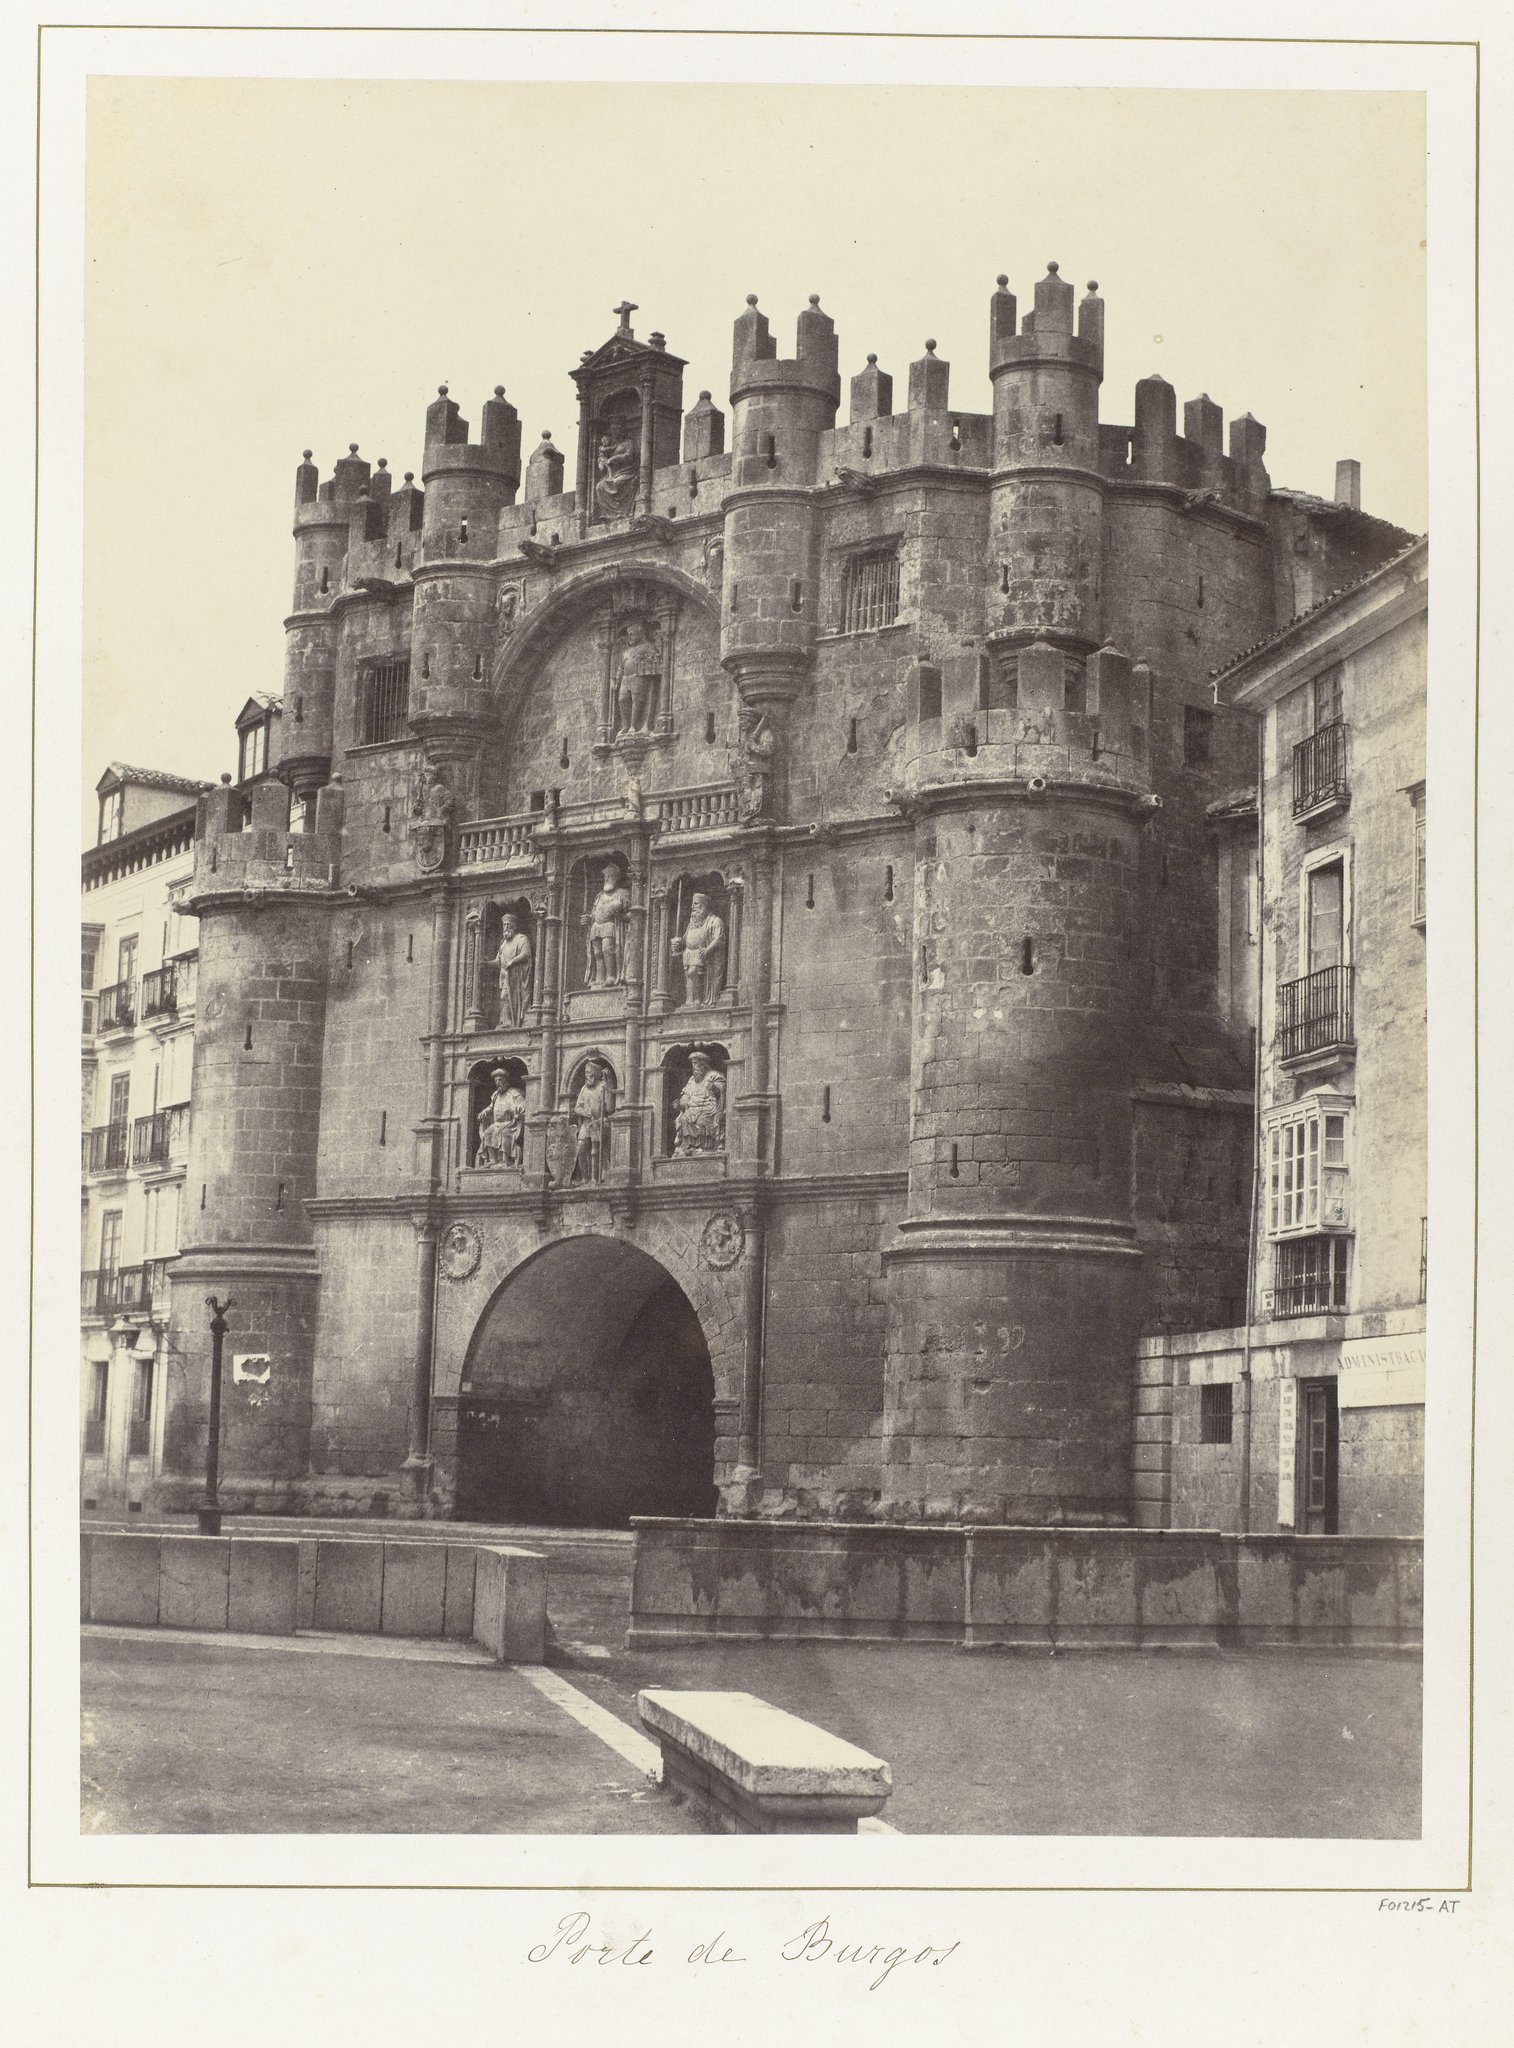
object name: photograph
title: Arco de Santa María in Burgos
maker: charles clifford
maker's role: fotograaf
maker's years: 1819-1863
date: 1850-1863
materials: photographic support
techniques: albumen print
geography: burgos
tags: gate ~ fortified city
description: Onderdeel van Reisalbum met opnames van kunstwerken, personen en bezienswaardigheden in Spanje.